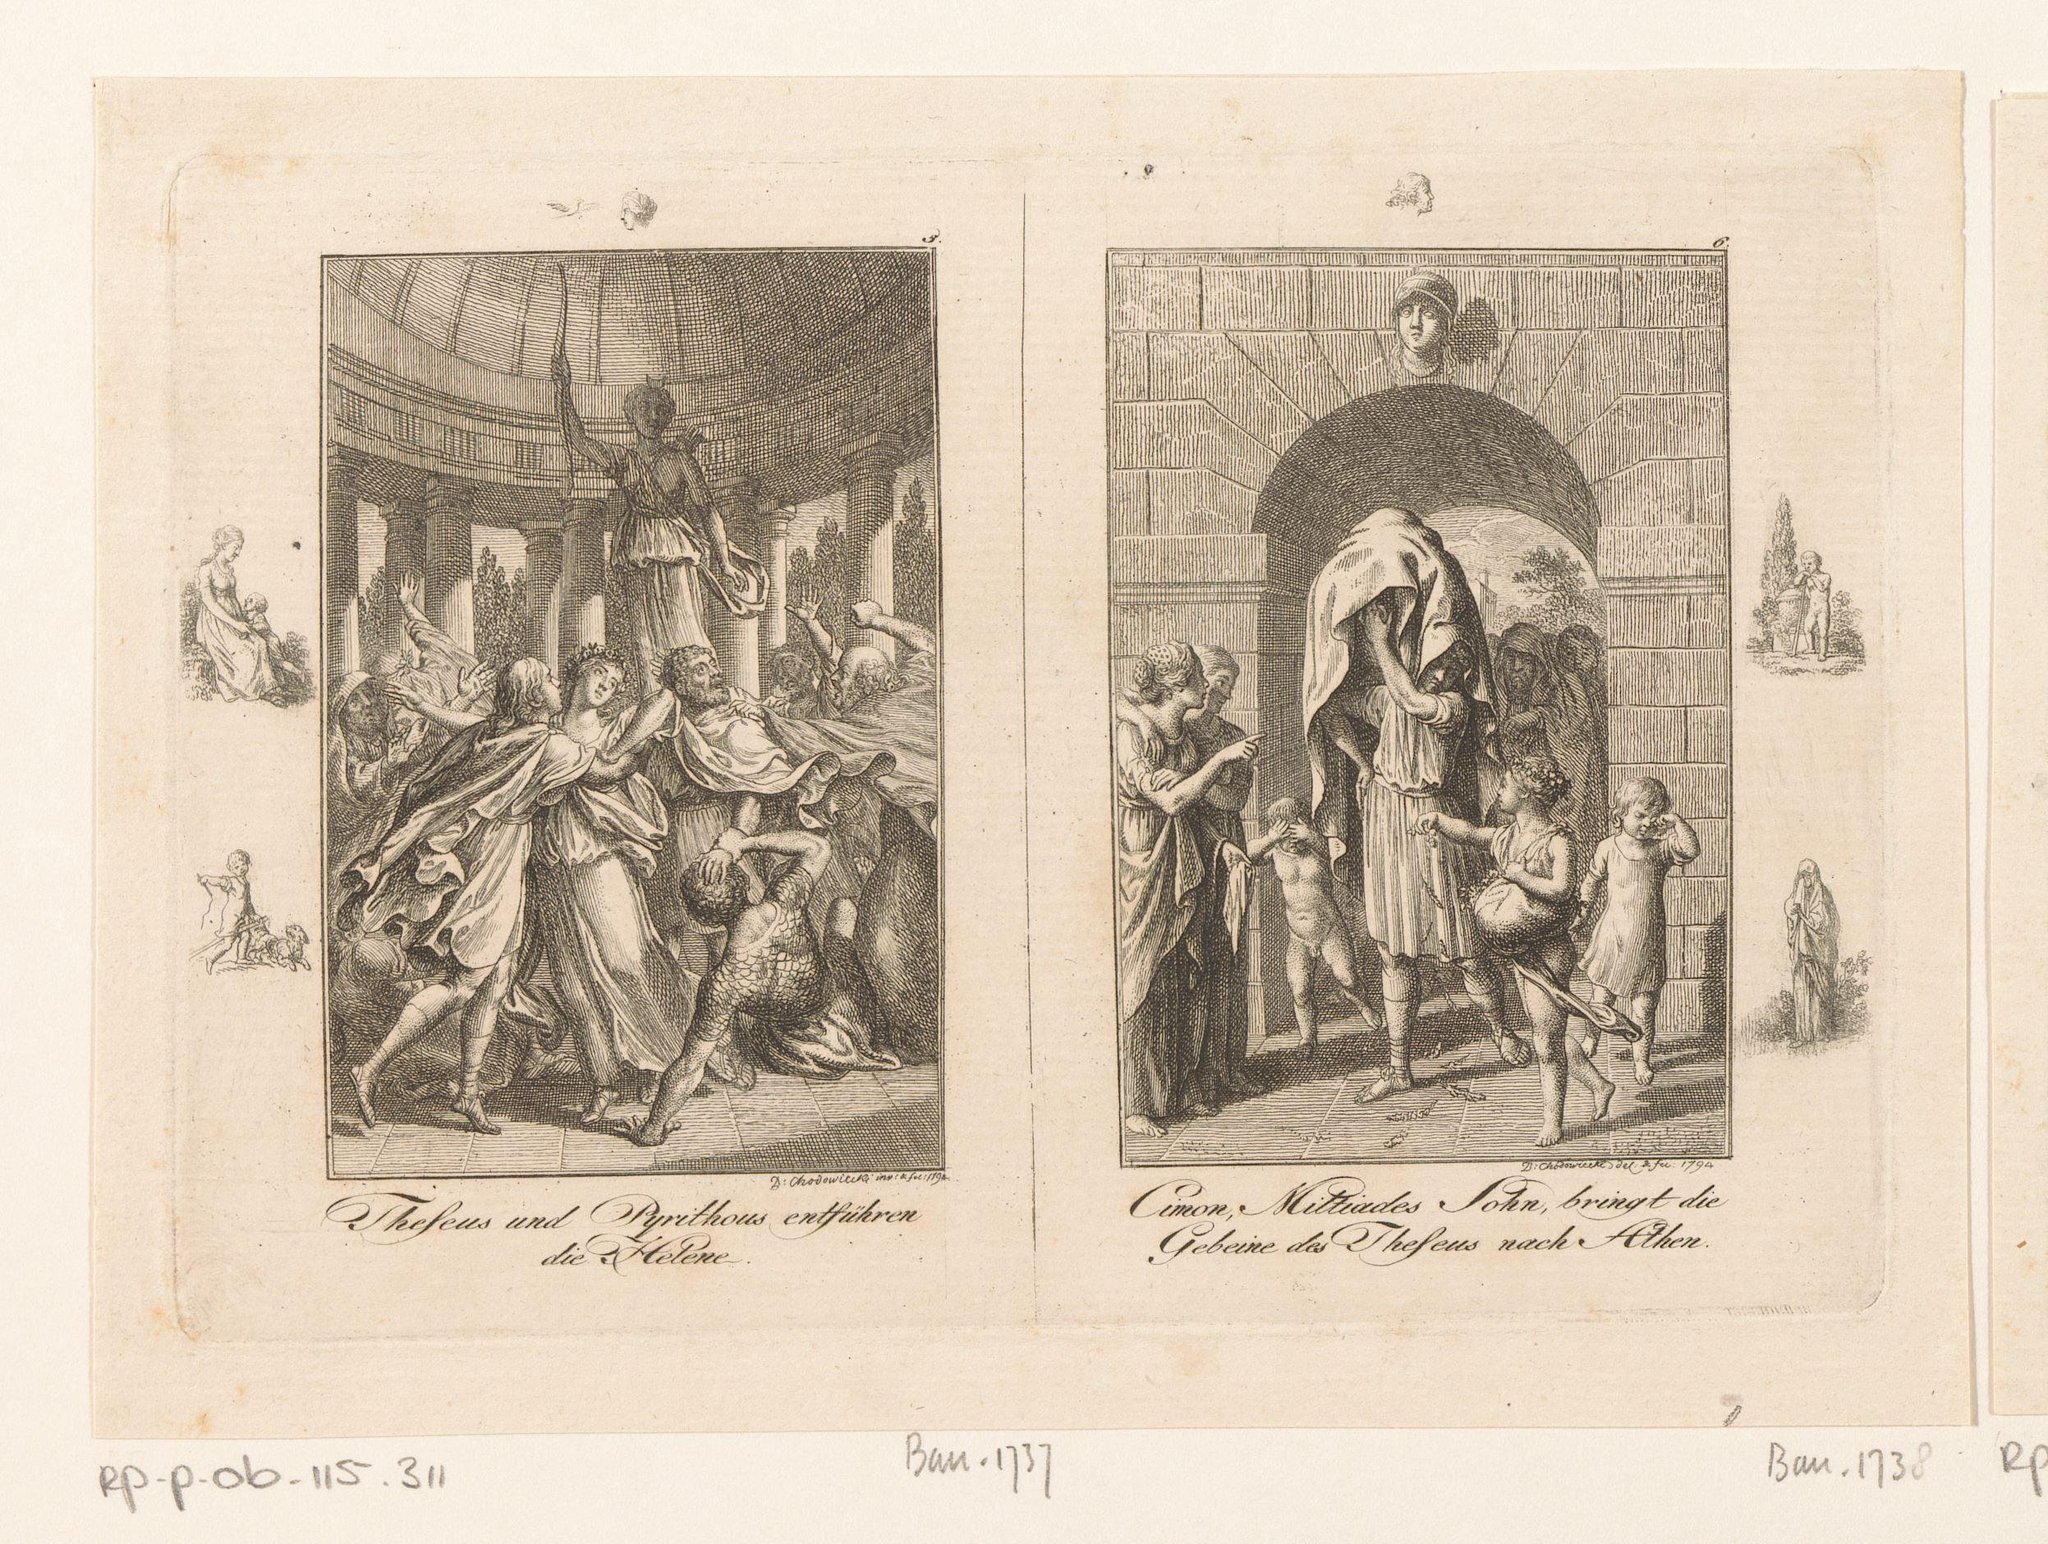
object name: print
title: Twee voorstellingen uit het leven van Theseus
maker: daniel nikolaus chodowiecki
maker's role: draughtsman, print maker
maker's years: 1726-1801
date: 1794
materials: paper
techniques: etching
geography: berlin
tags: theseus and pirithous abducting helen, cimon, the athenian, brings theseus' bones back to his city, (story of) theseus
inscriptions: collector's mark: Lugt 2228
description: Links: De ontvoering van Helena. Rechts: Kimon draagt de botten van Theseus Athene binnen. Met onderschrift in het Duits en linksboven genummerd: 5,6. In de marge zijn op schetsmatige wijze verschillende koppen en figuren geëtst.